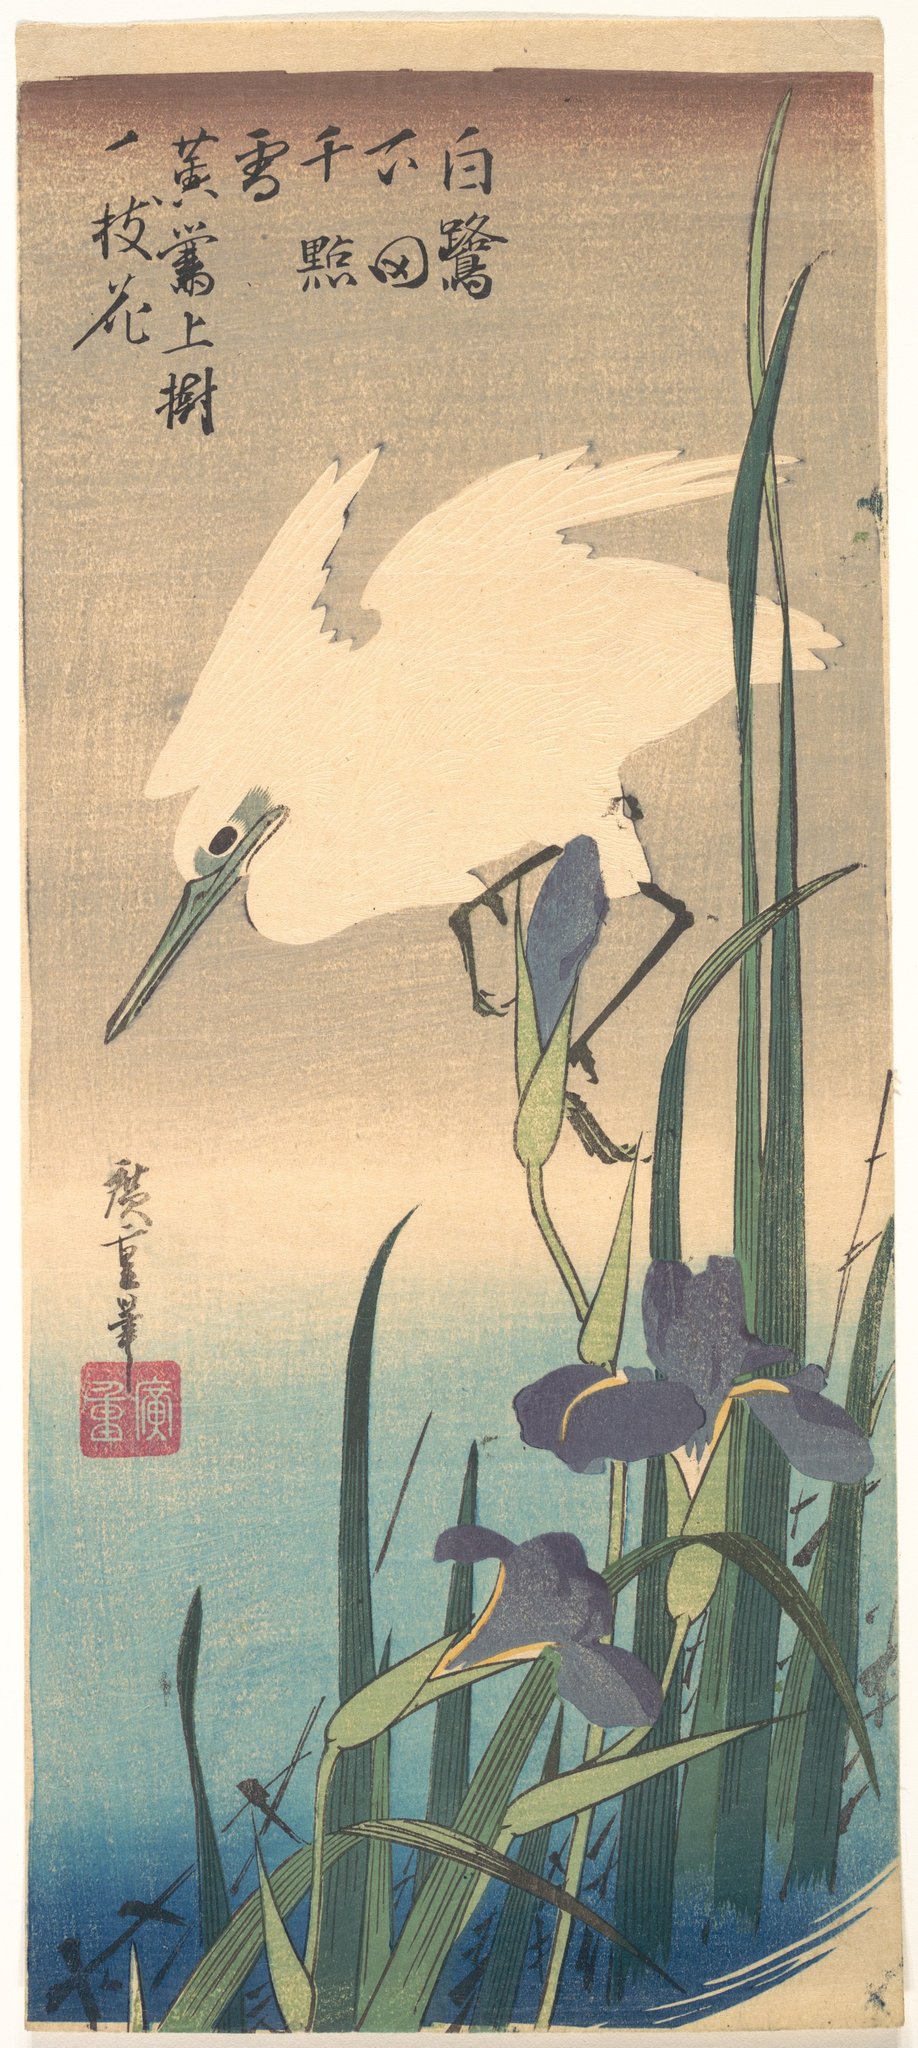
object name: print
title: White Heron and Iris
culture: japanese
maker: utagawa hiroshige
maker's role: artist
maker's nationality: japanese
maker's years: 1797-1858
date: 1800-1858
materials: ink, paper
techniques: woodblock print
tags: birds,flowers